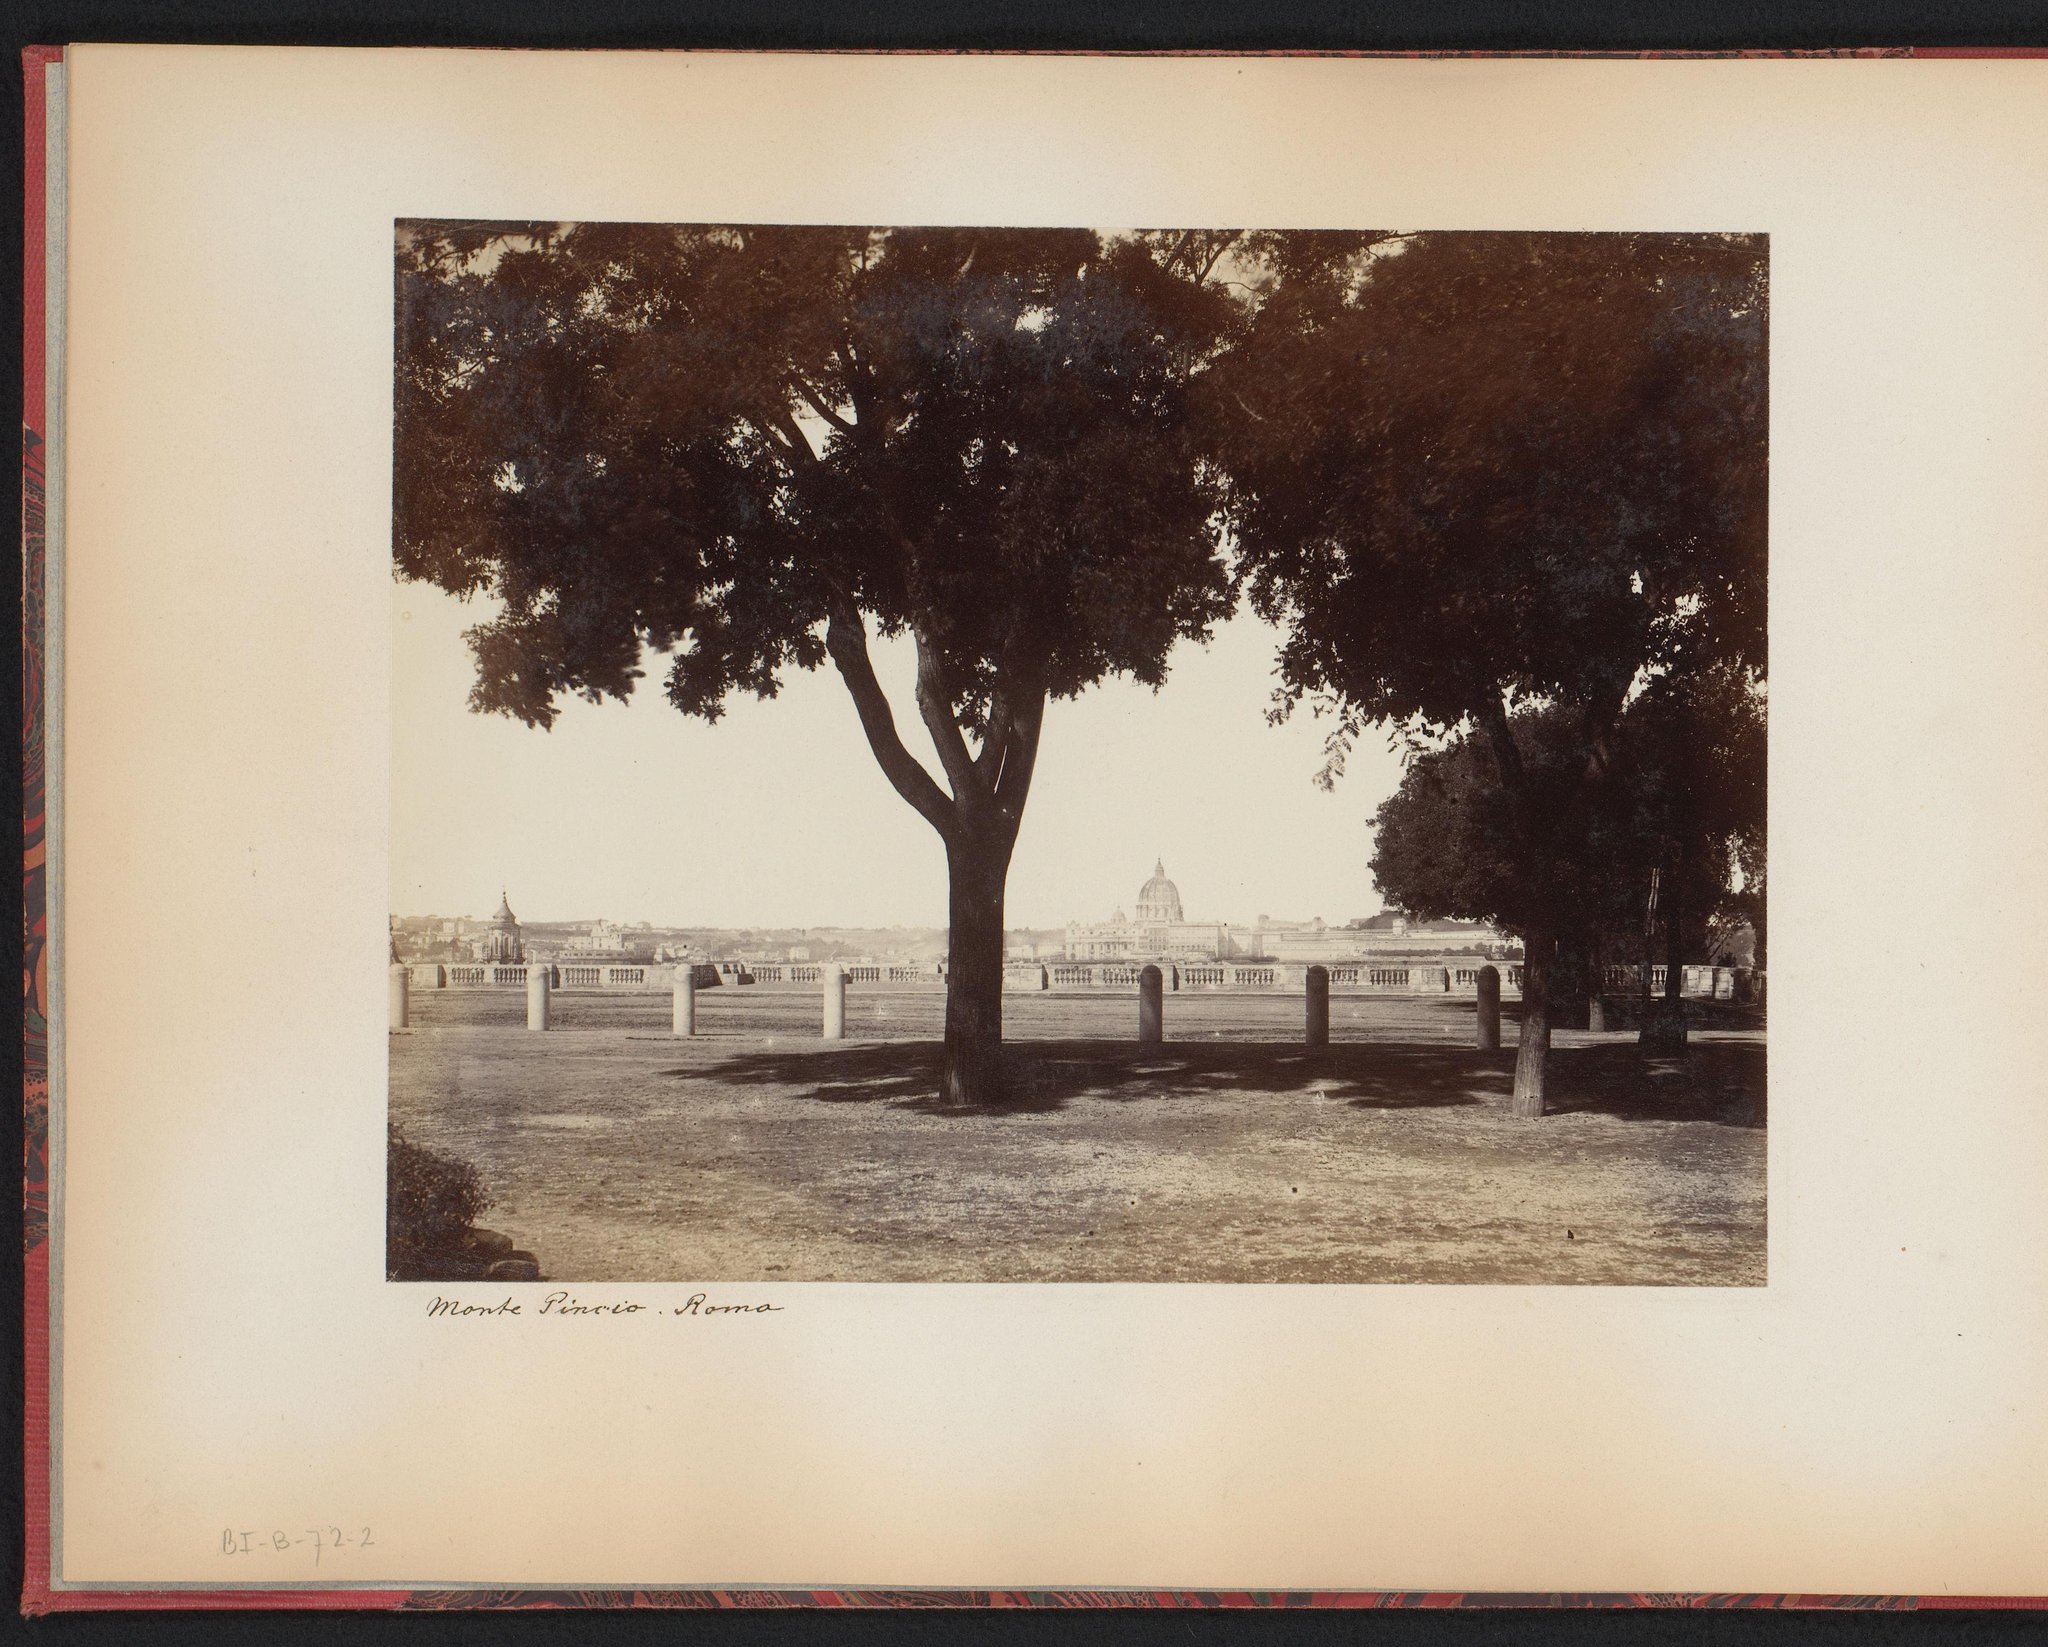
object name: photograph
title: Gezicht op Rome vanaf de Monte Pincio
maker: Anonymous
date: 1870-1890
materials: paper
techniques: albumen print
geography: pincio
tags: trees, city-view in general; 'veduta', garden, church (exterior), public gardens, park, rome